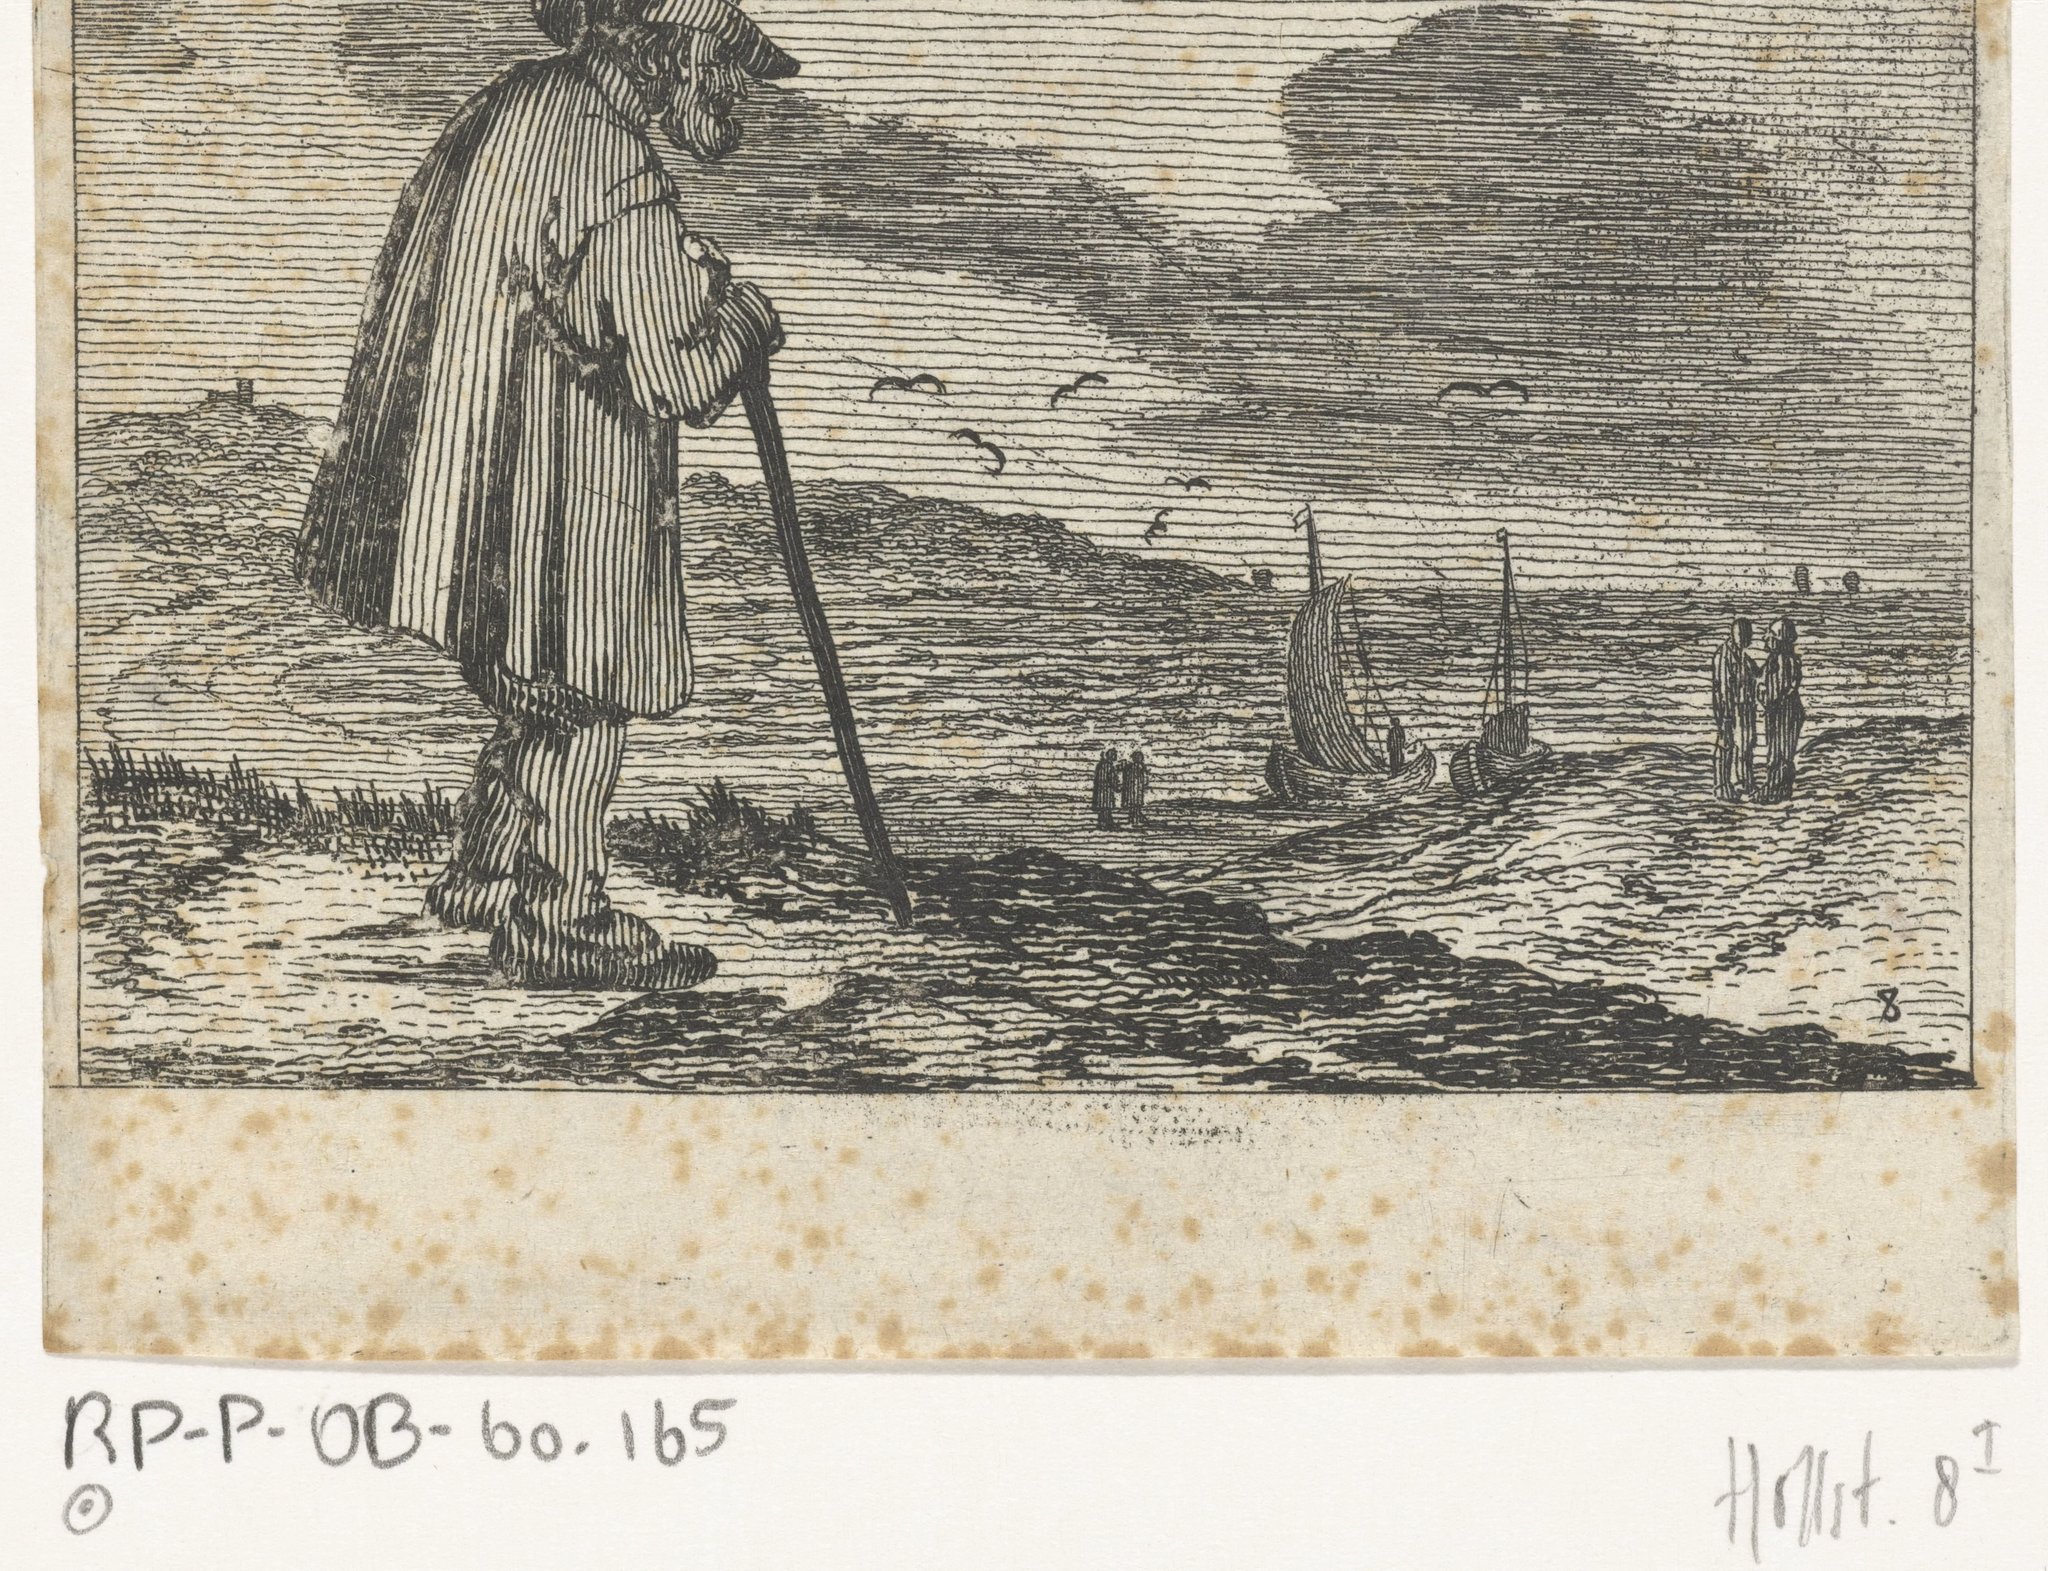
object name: print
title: Duinlandschap met een oude man, leunend op een wandelstok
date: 1618-1645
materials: paper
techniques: etching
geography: northern netherlands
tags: dune coast, walking-stick, staff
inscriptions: collector's mark: Lugt 240